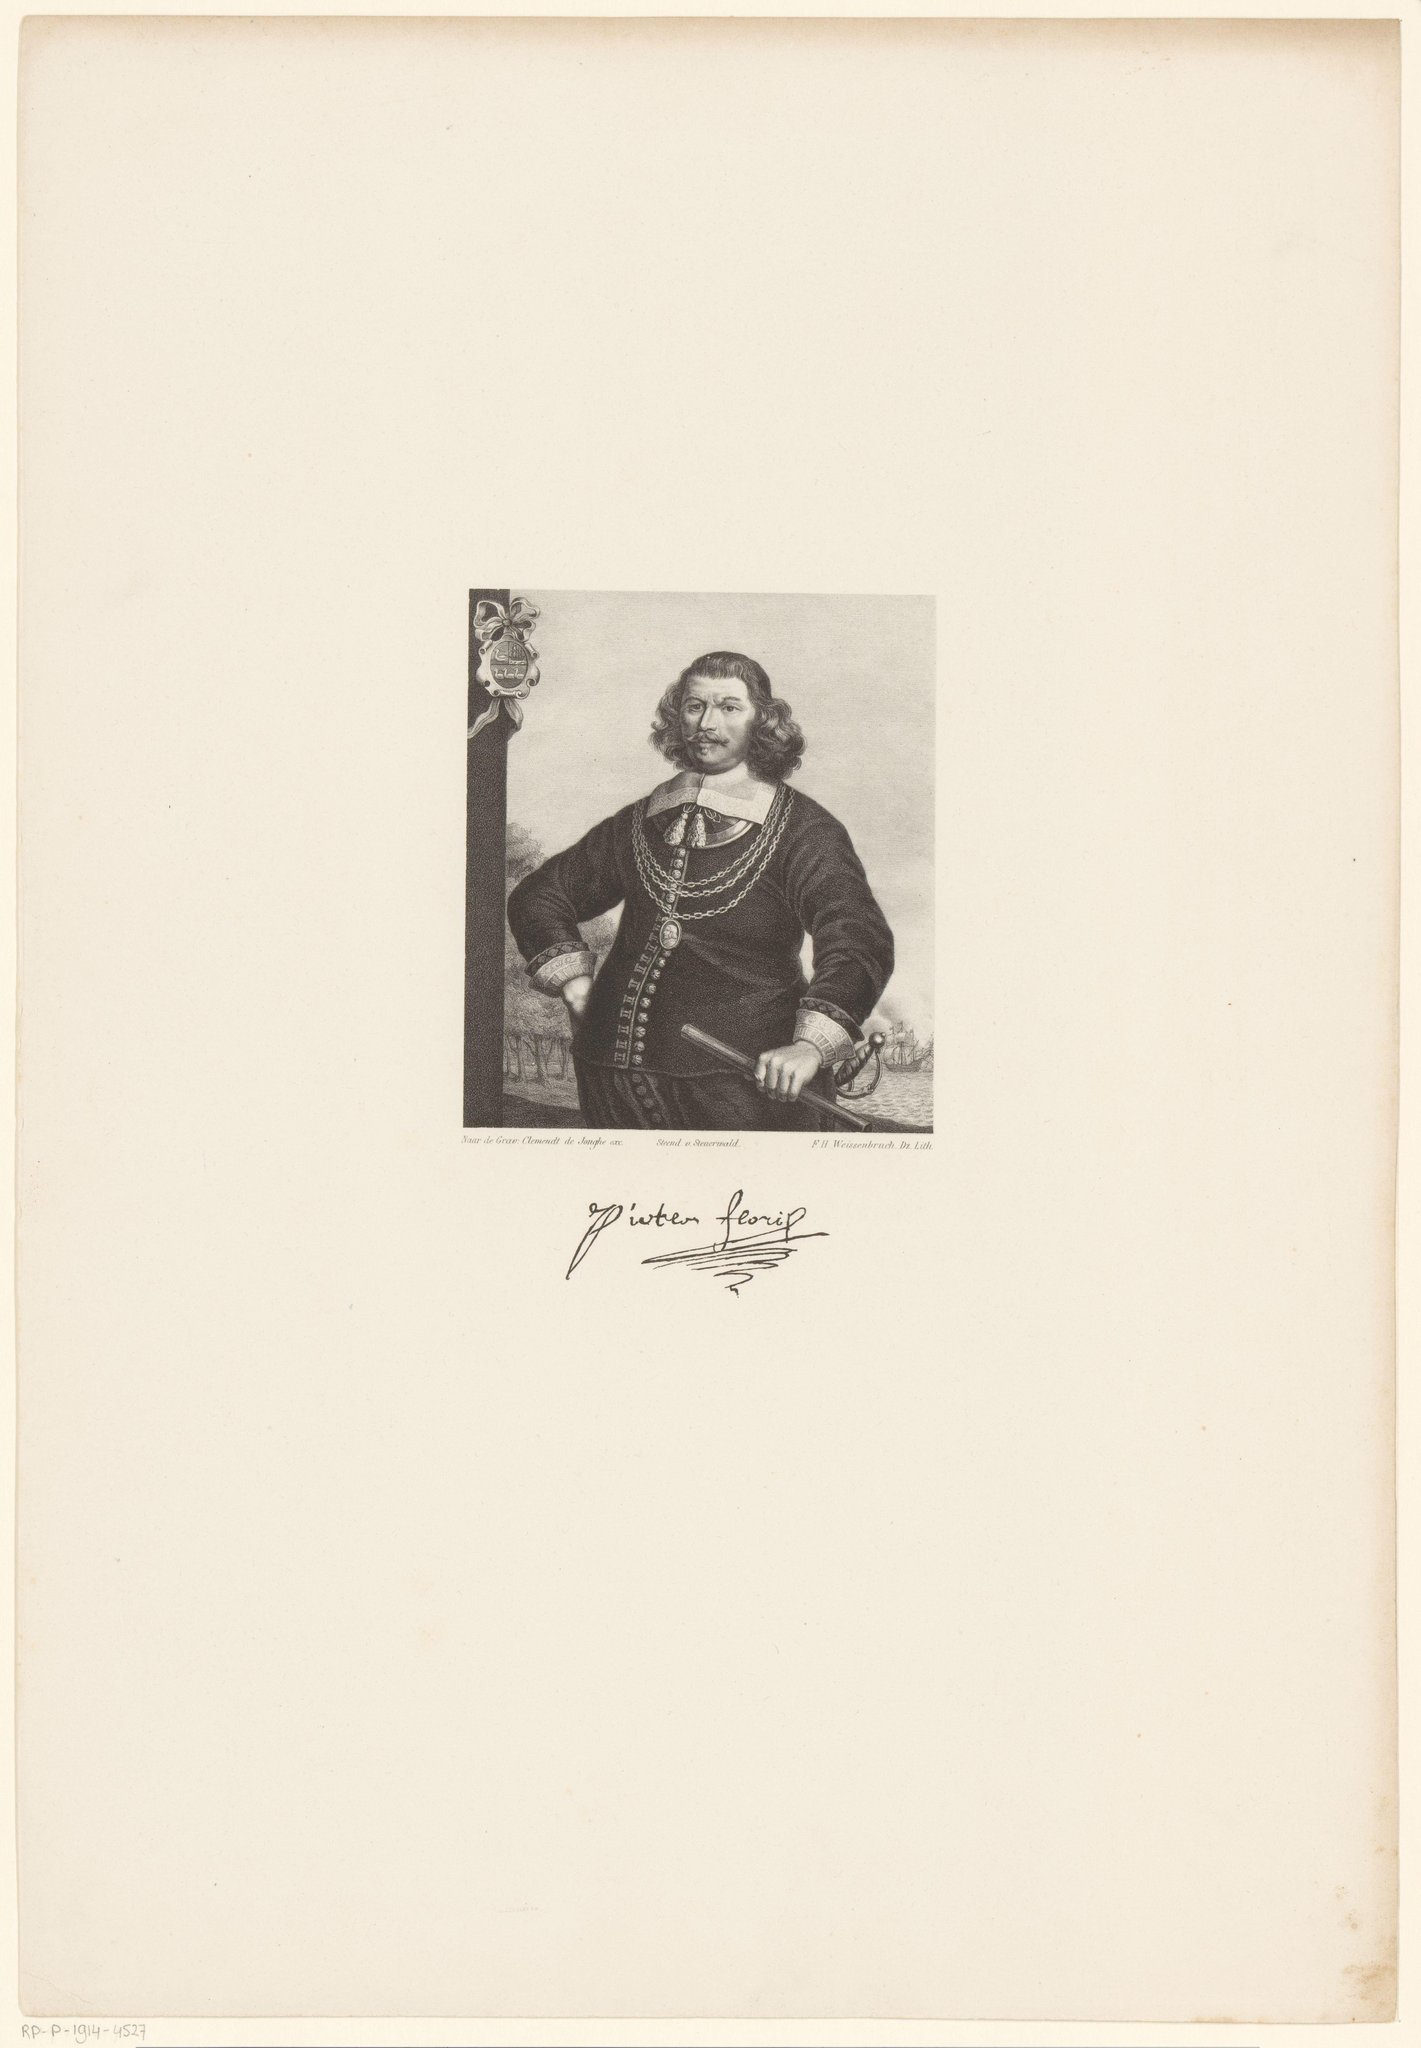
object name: book illustration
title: Pieter Florisse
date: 1858-1862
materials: paper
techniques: lithograph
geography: the hague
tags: historical persons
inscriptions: collector's mark: Lugt 2228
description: Prent uit: Jonge, J.C. de. Geschiedenis van het Nederlandsche zeewezen. Haarlem: Jonge, J.K.J. de, 1858-62.